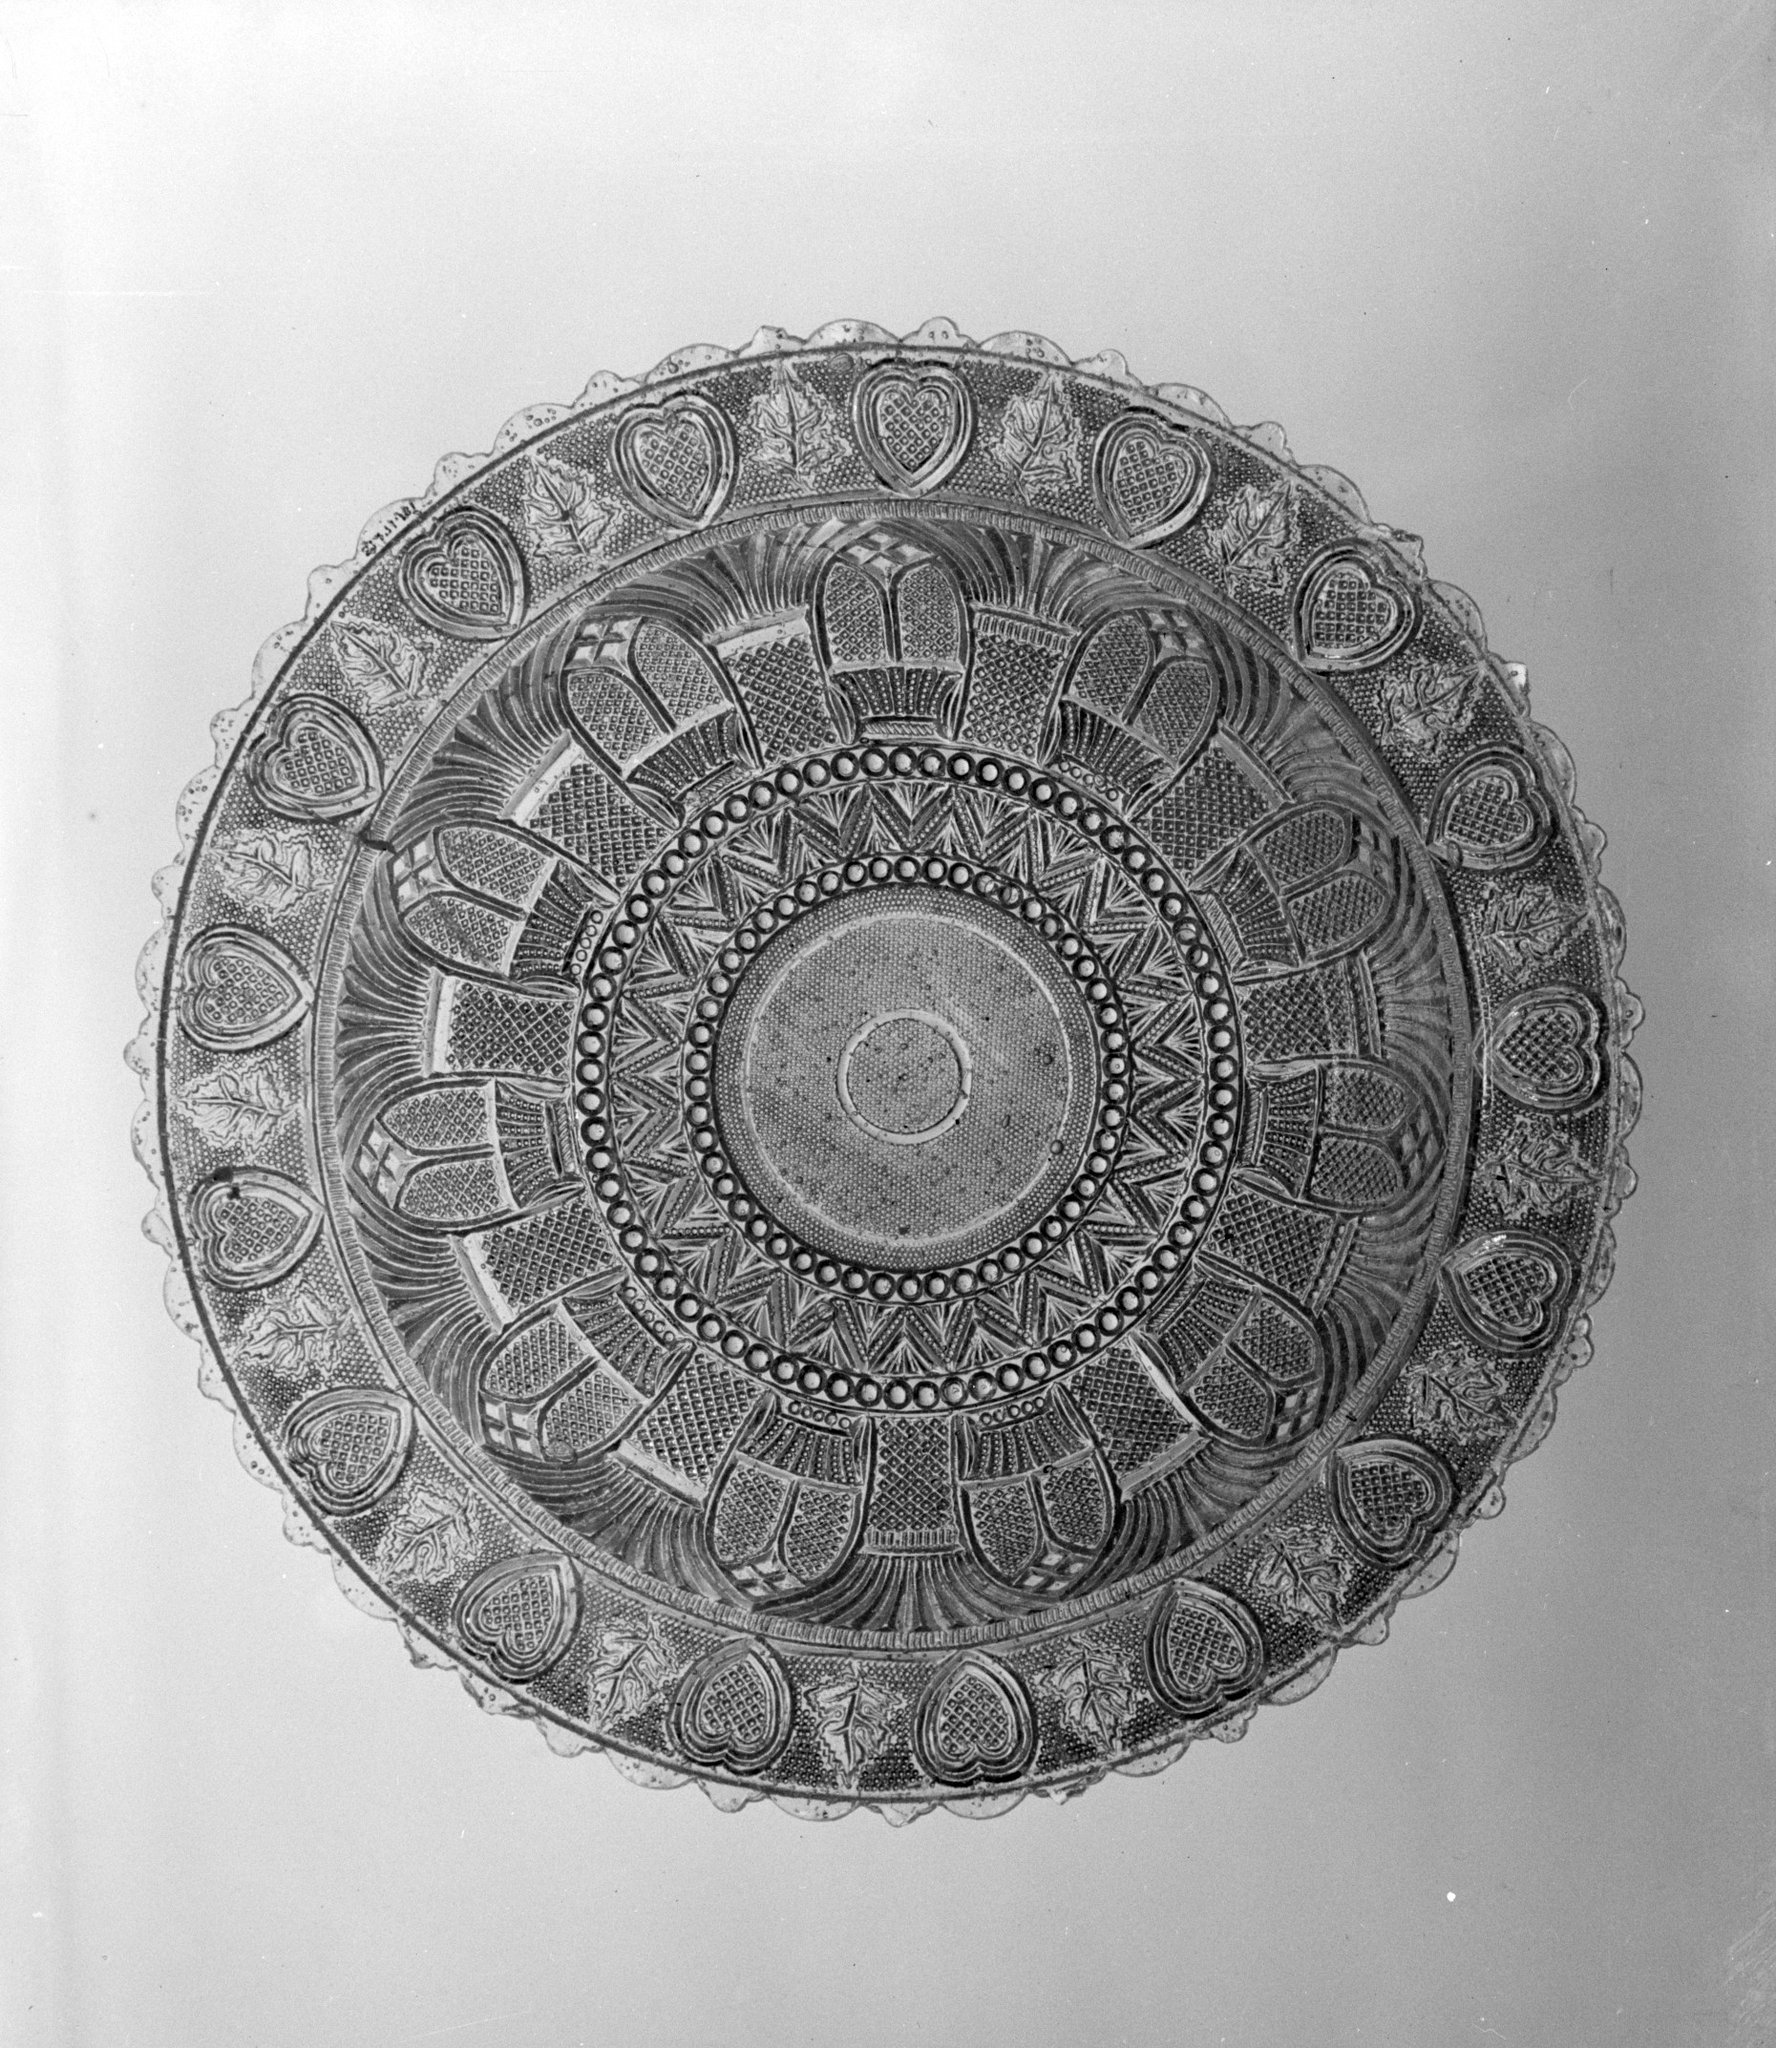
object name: bowl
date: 1801-1900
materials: glass